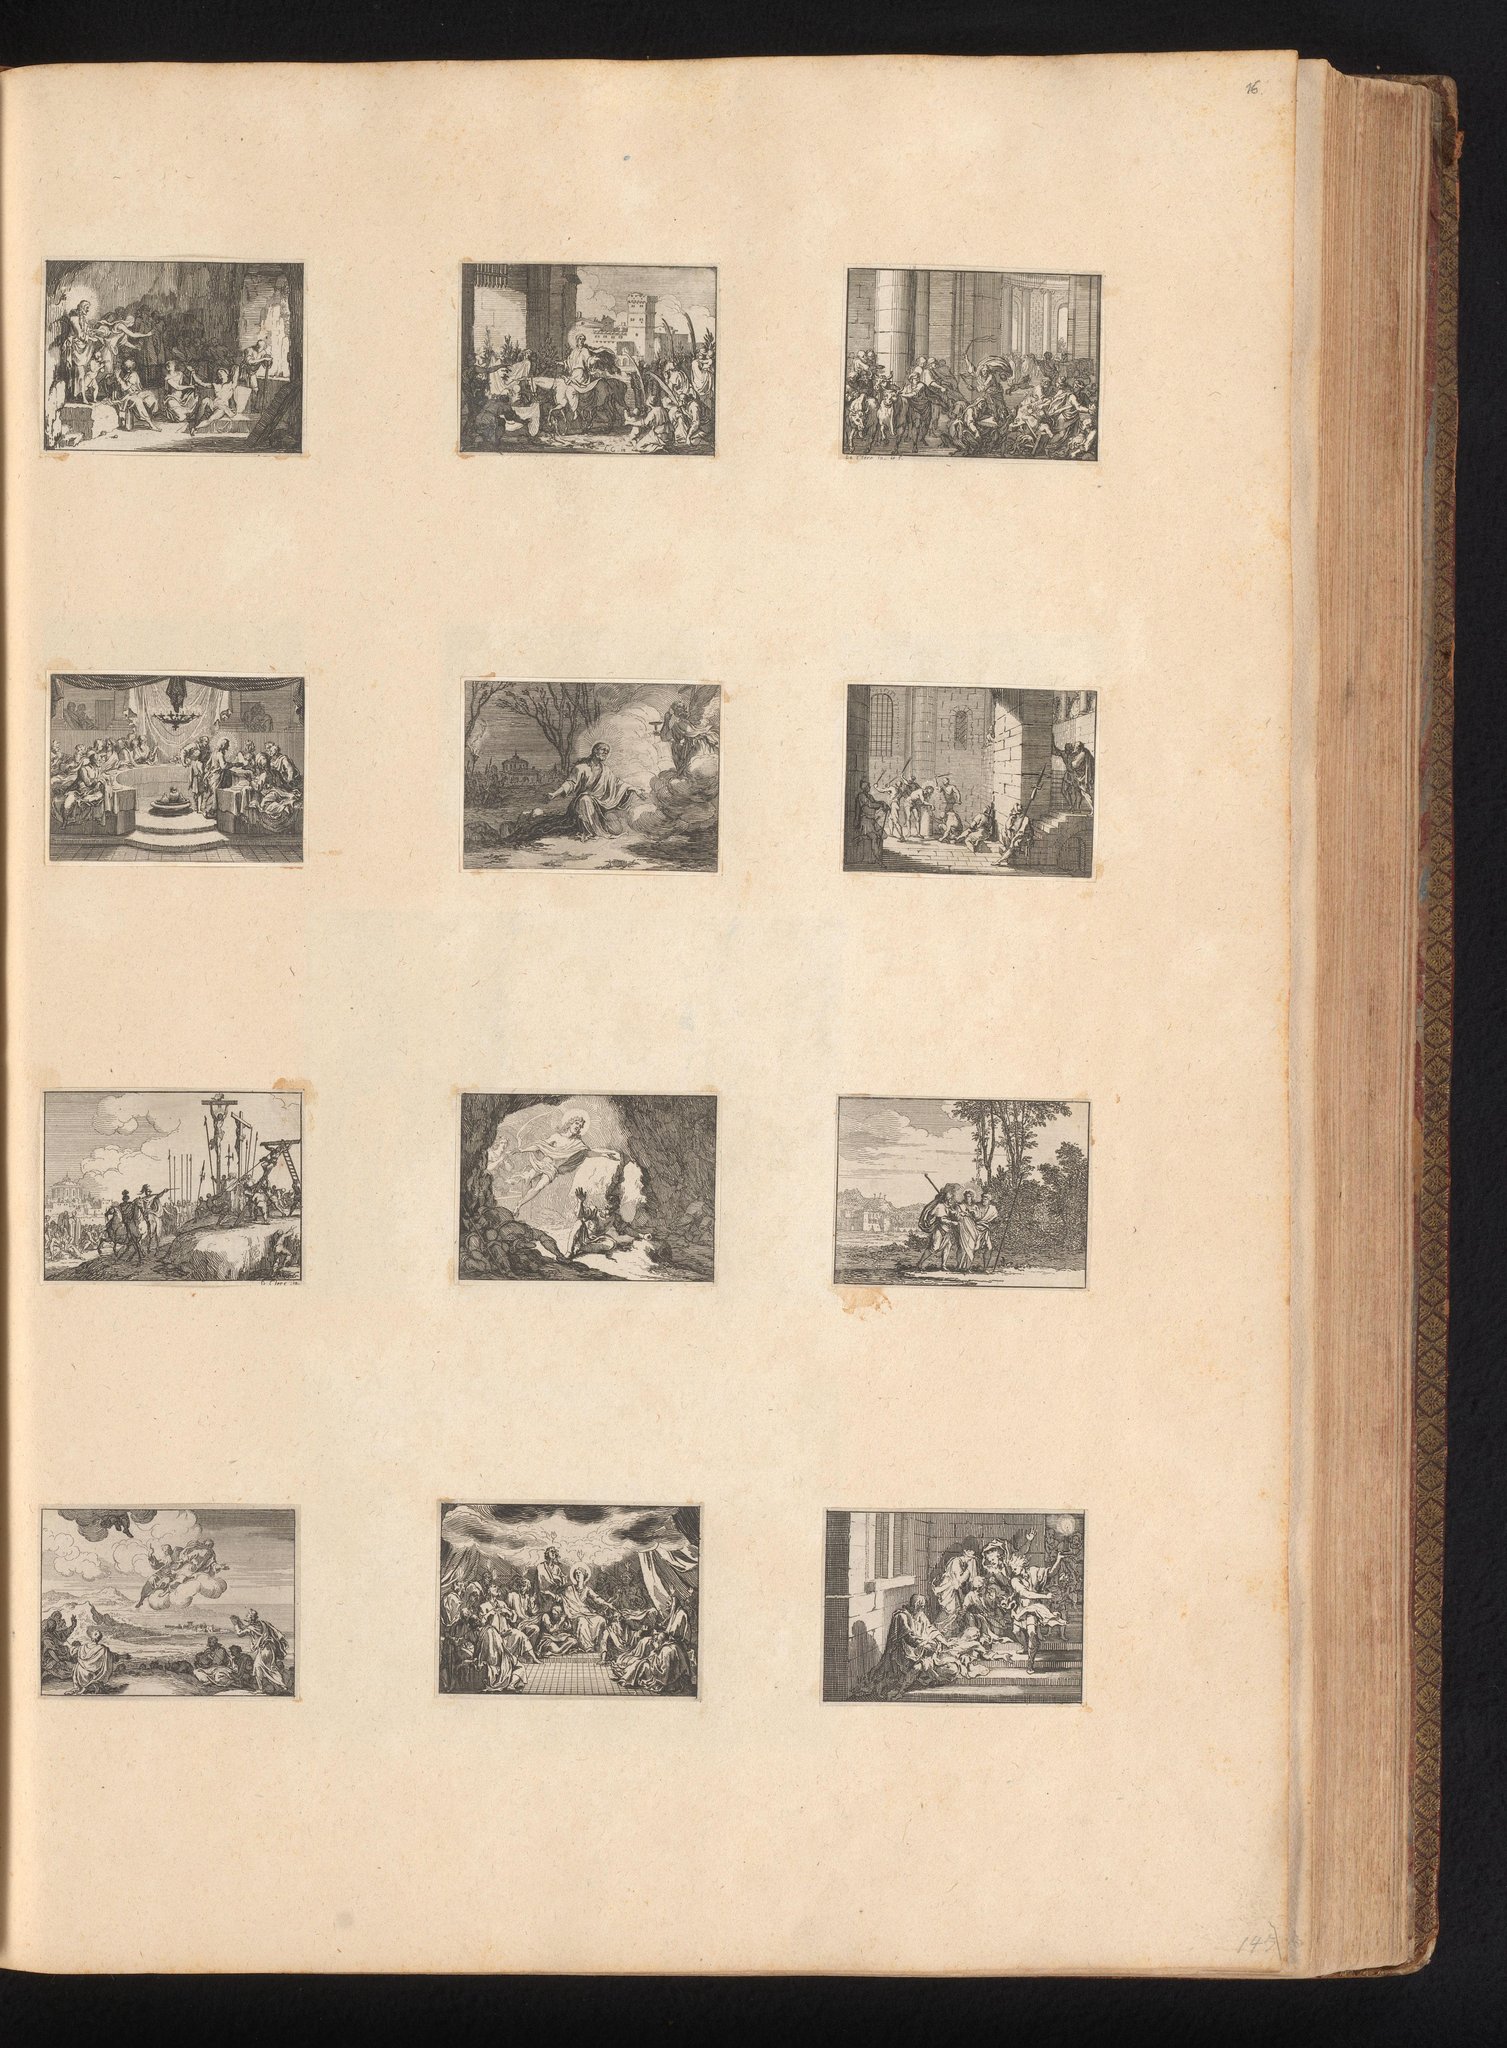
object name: print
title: Voorstellingen uit het Nieuwe Testament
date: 1675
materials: paper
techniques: etching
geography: paris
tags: new testament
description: Prenten gebruikt voor het derde deel van: Brianville, Finé de. Histoire sacrée en tableaux (...). Parijs: Charles de Sercy, 1675. In dit boek staan verschillende voorstellingen uit het Nieuwe Testament.